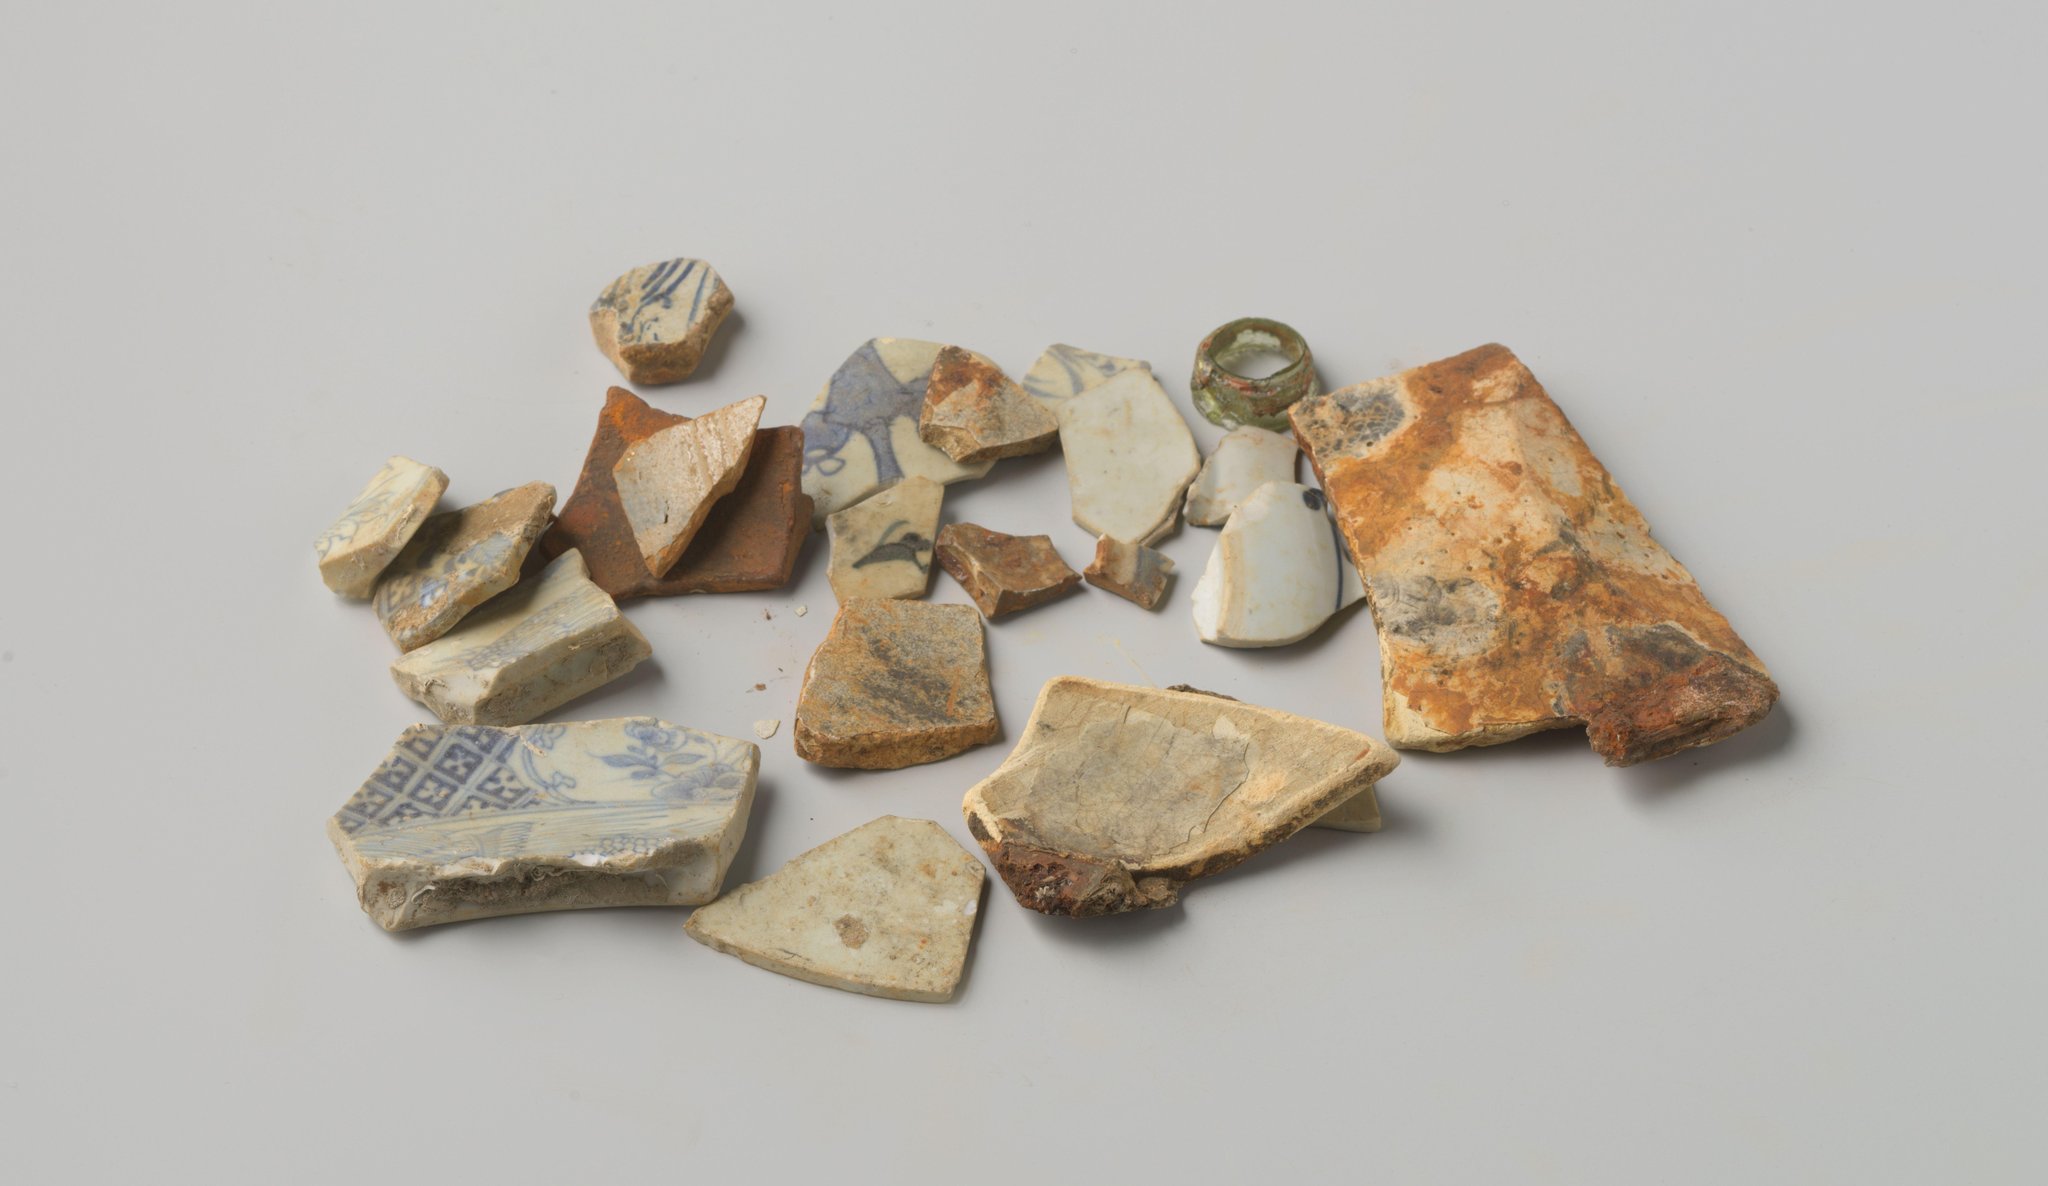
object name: sherd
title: Scherven aardewerk, porselein en glas uit het wrak van de Oost-Indiëvaarder Hollandia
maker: Anonymous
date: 1700-1743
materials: earthenware, glaze, glass, porcelain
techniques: green glass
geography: delft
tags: verenigde oostindische compagnie, hollandia (schip), annet